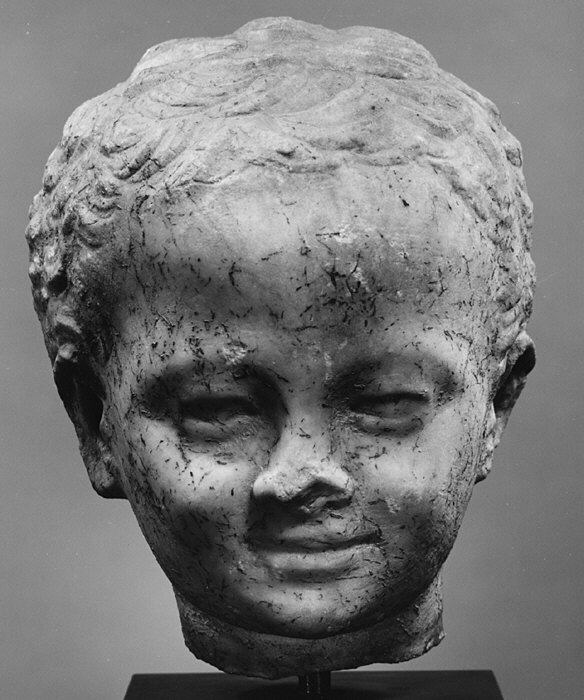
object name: head of a child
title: Marble head of a child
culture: greek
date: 300-101 BCE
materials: marble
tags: heads